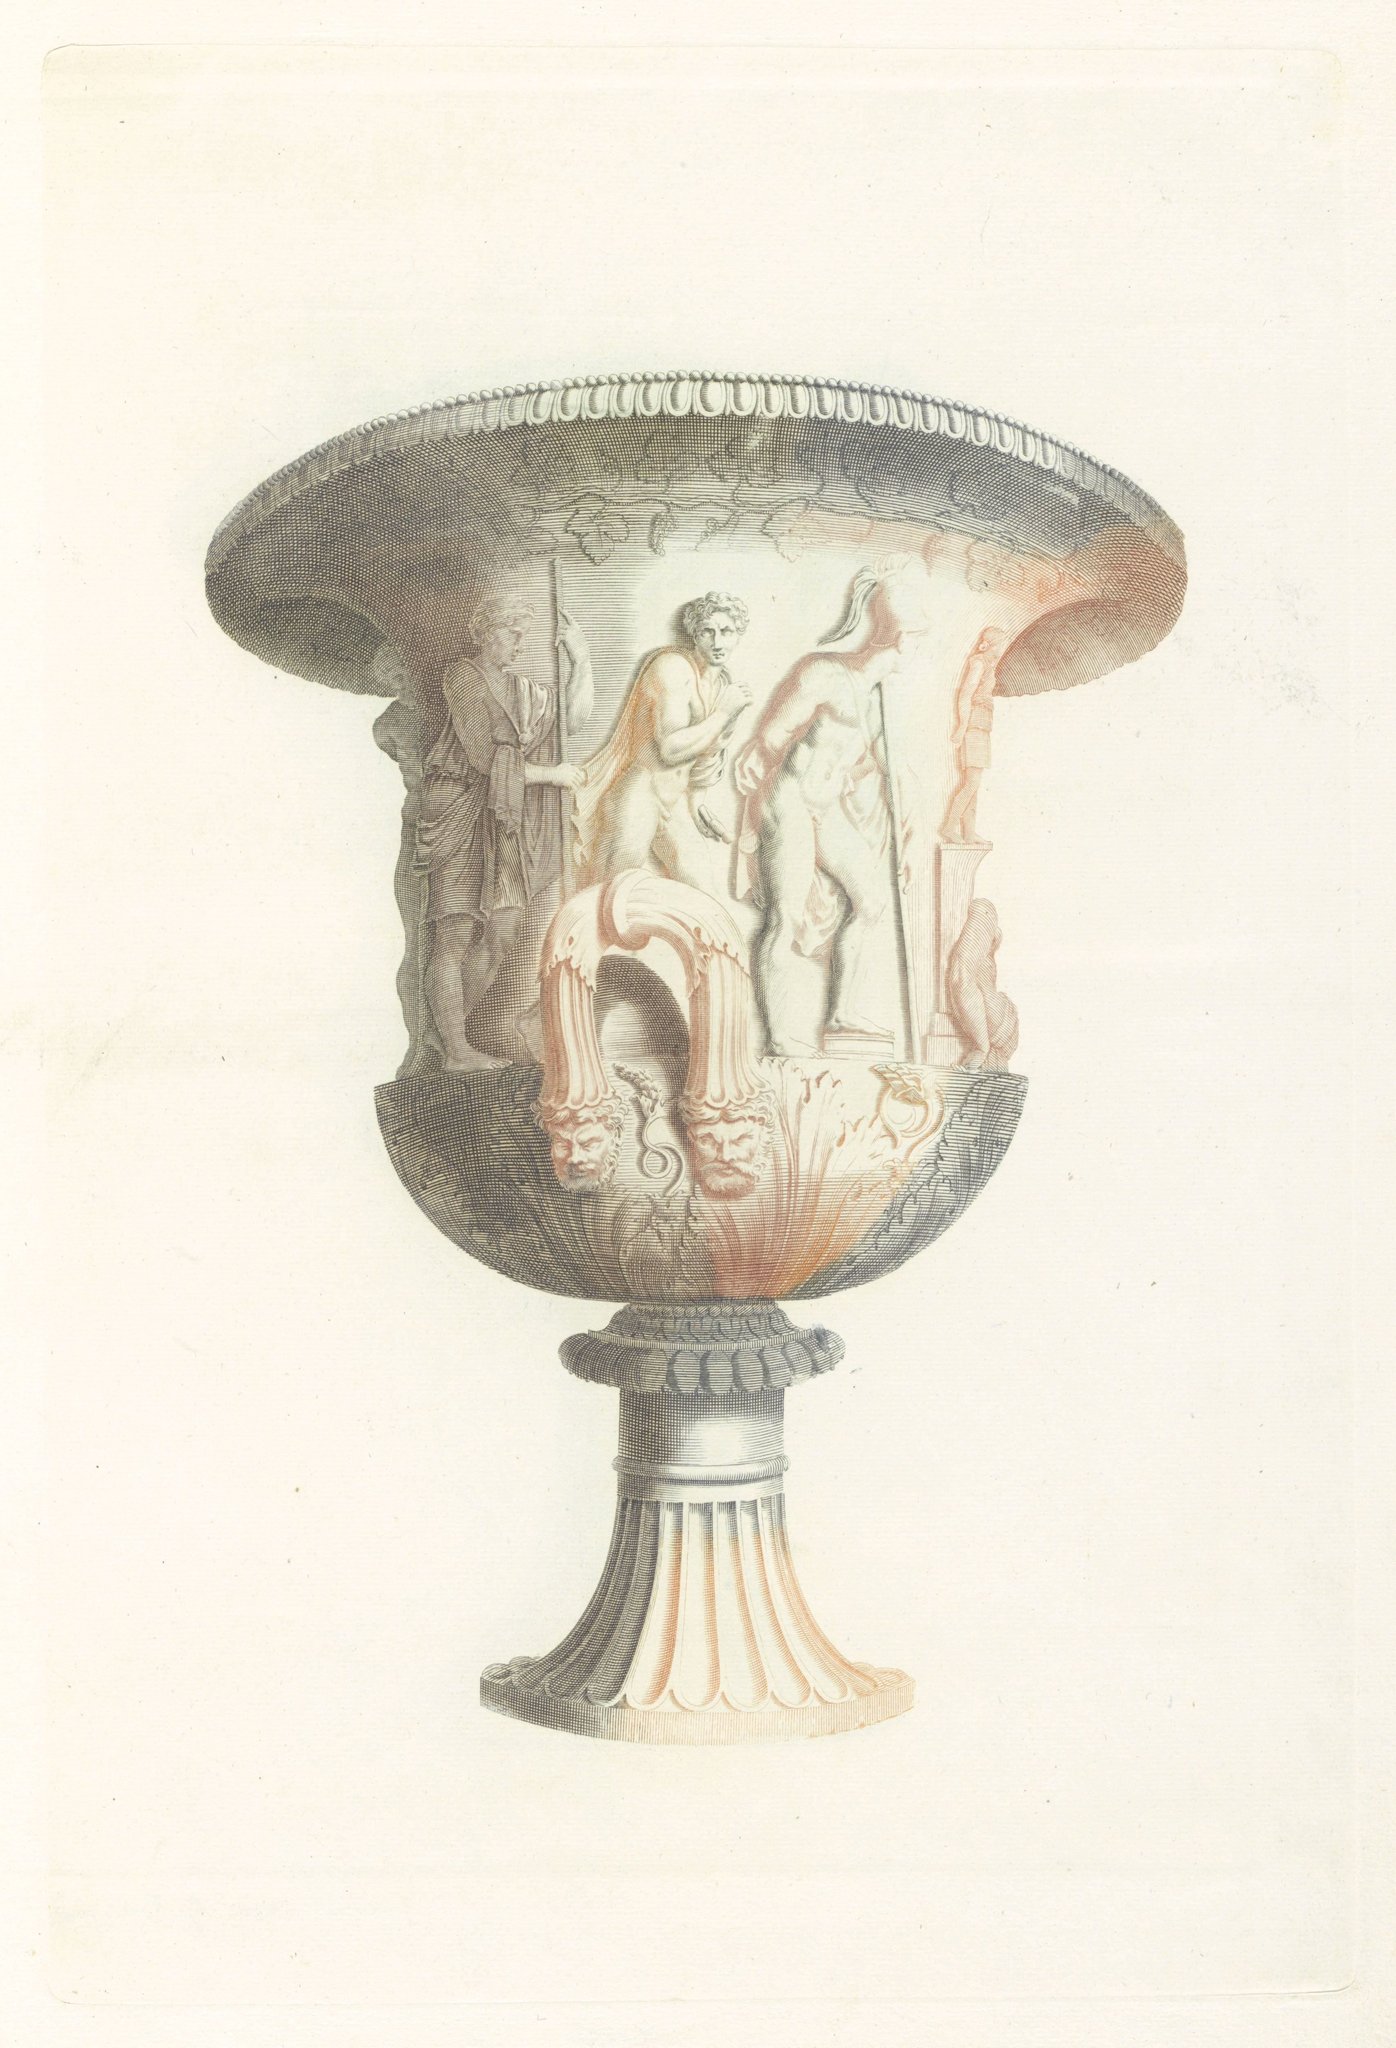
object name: print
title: Medici vaas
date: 1688-1698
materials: paper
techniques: printing, engraving, lithography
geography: netherlands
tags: vase ~ ornament, garden vase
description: Op het lichaam, onder een uitwaaierende rand met een wijnrank, staat een aantal klassieke figuren, waarvan twee met een staf. Deze prent maakt deel uit van een album.